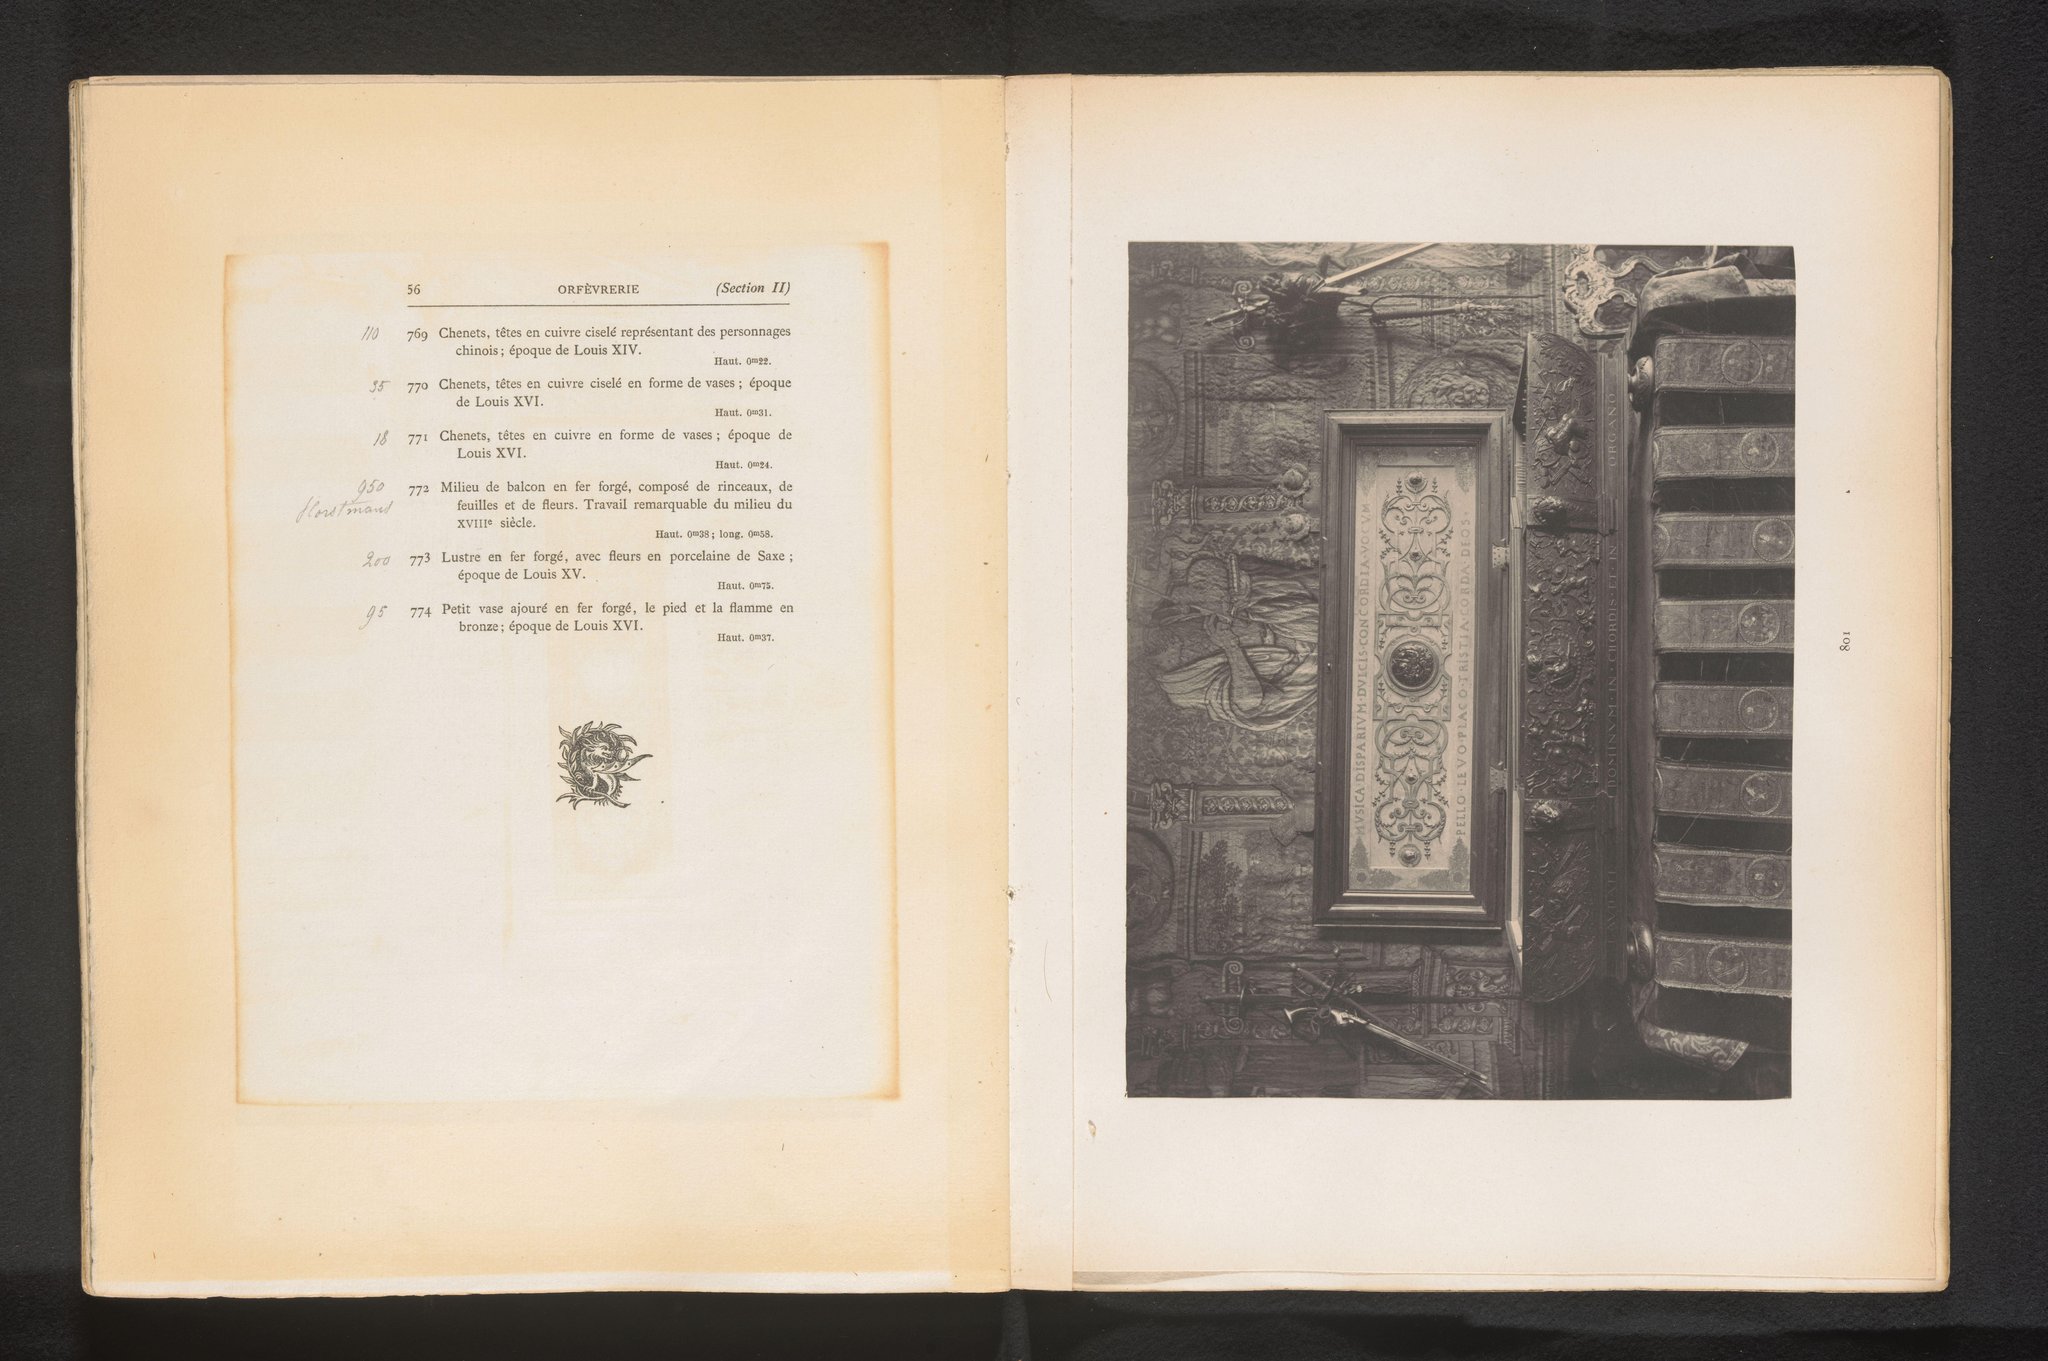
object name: photograph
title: Virginaal uit de collectie van Antonin Terme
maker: Anonymous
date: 1880-1885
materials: photographic support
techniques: platinum process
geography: liège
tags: art collection, art gallery, spinet, virginal